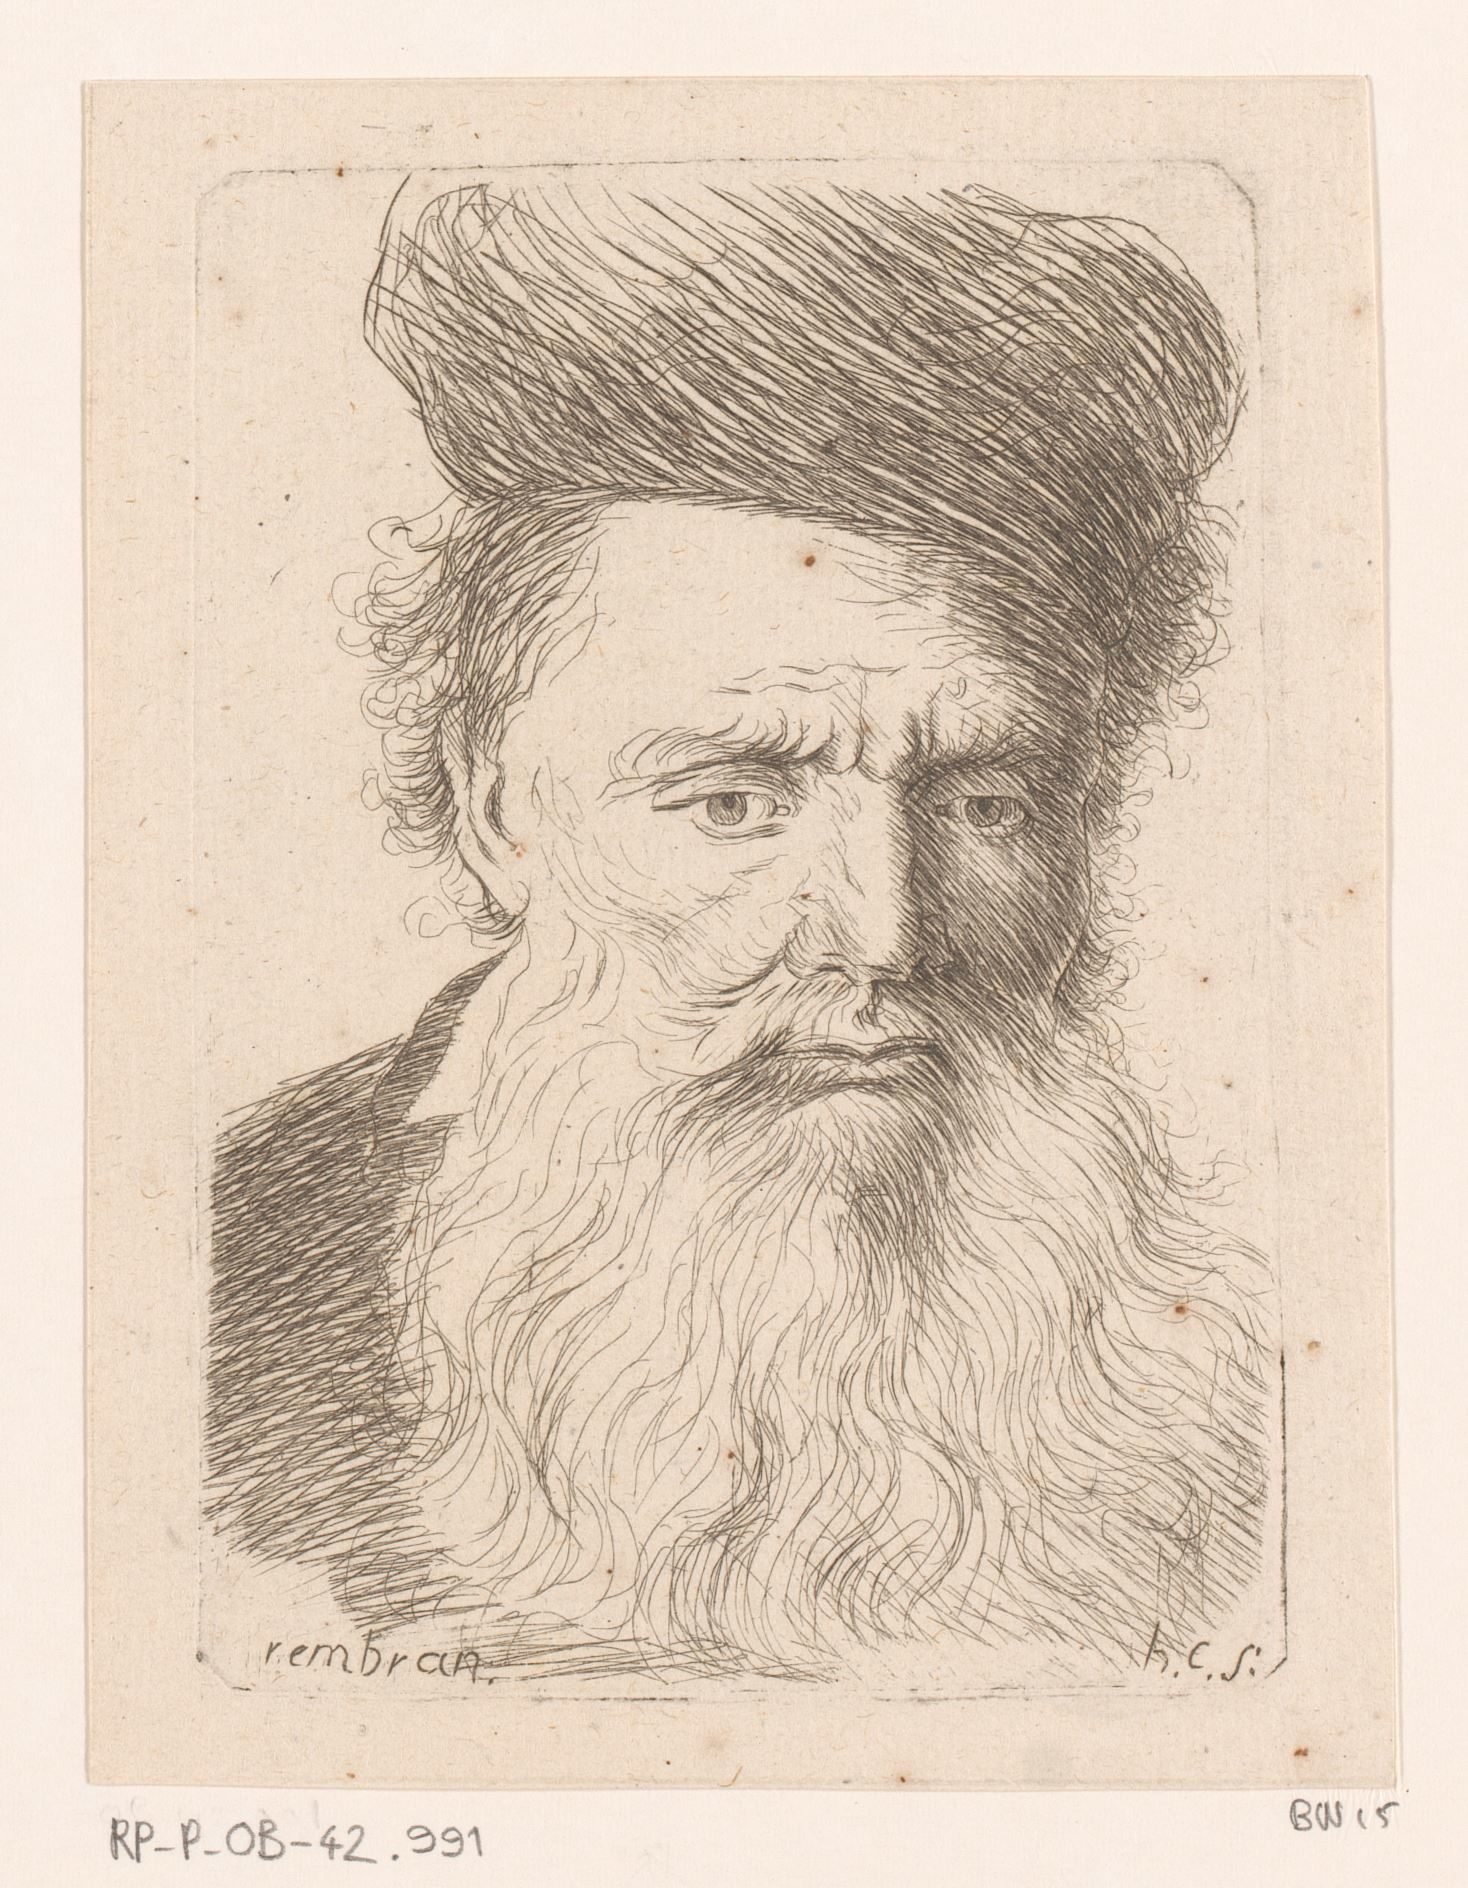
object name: print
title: Buste van een oude man met baard en bontmuts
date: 1708-1779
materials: paper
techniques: etching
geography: france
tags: head-gear (with name), old man, beard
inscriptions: collector's mark: Lugt 240